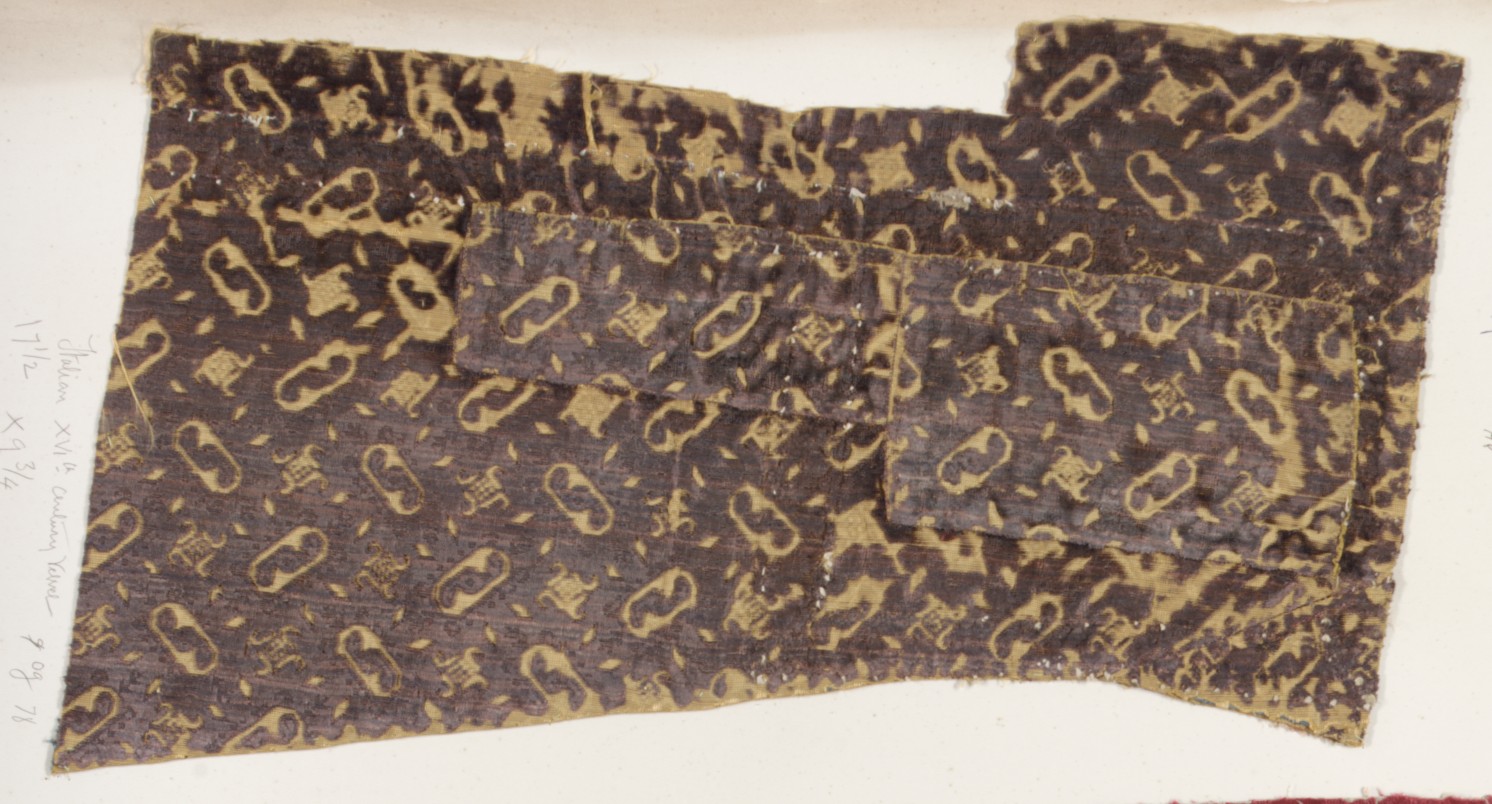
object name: fragment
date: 1501-1600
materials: silk